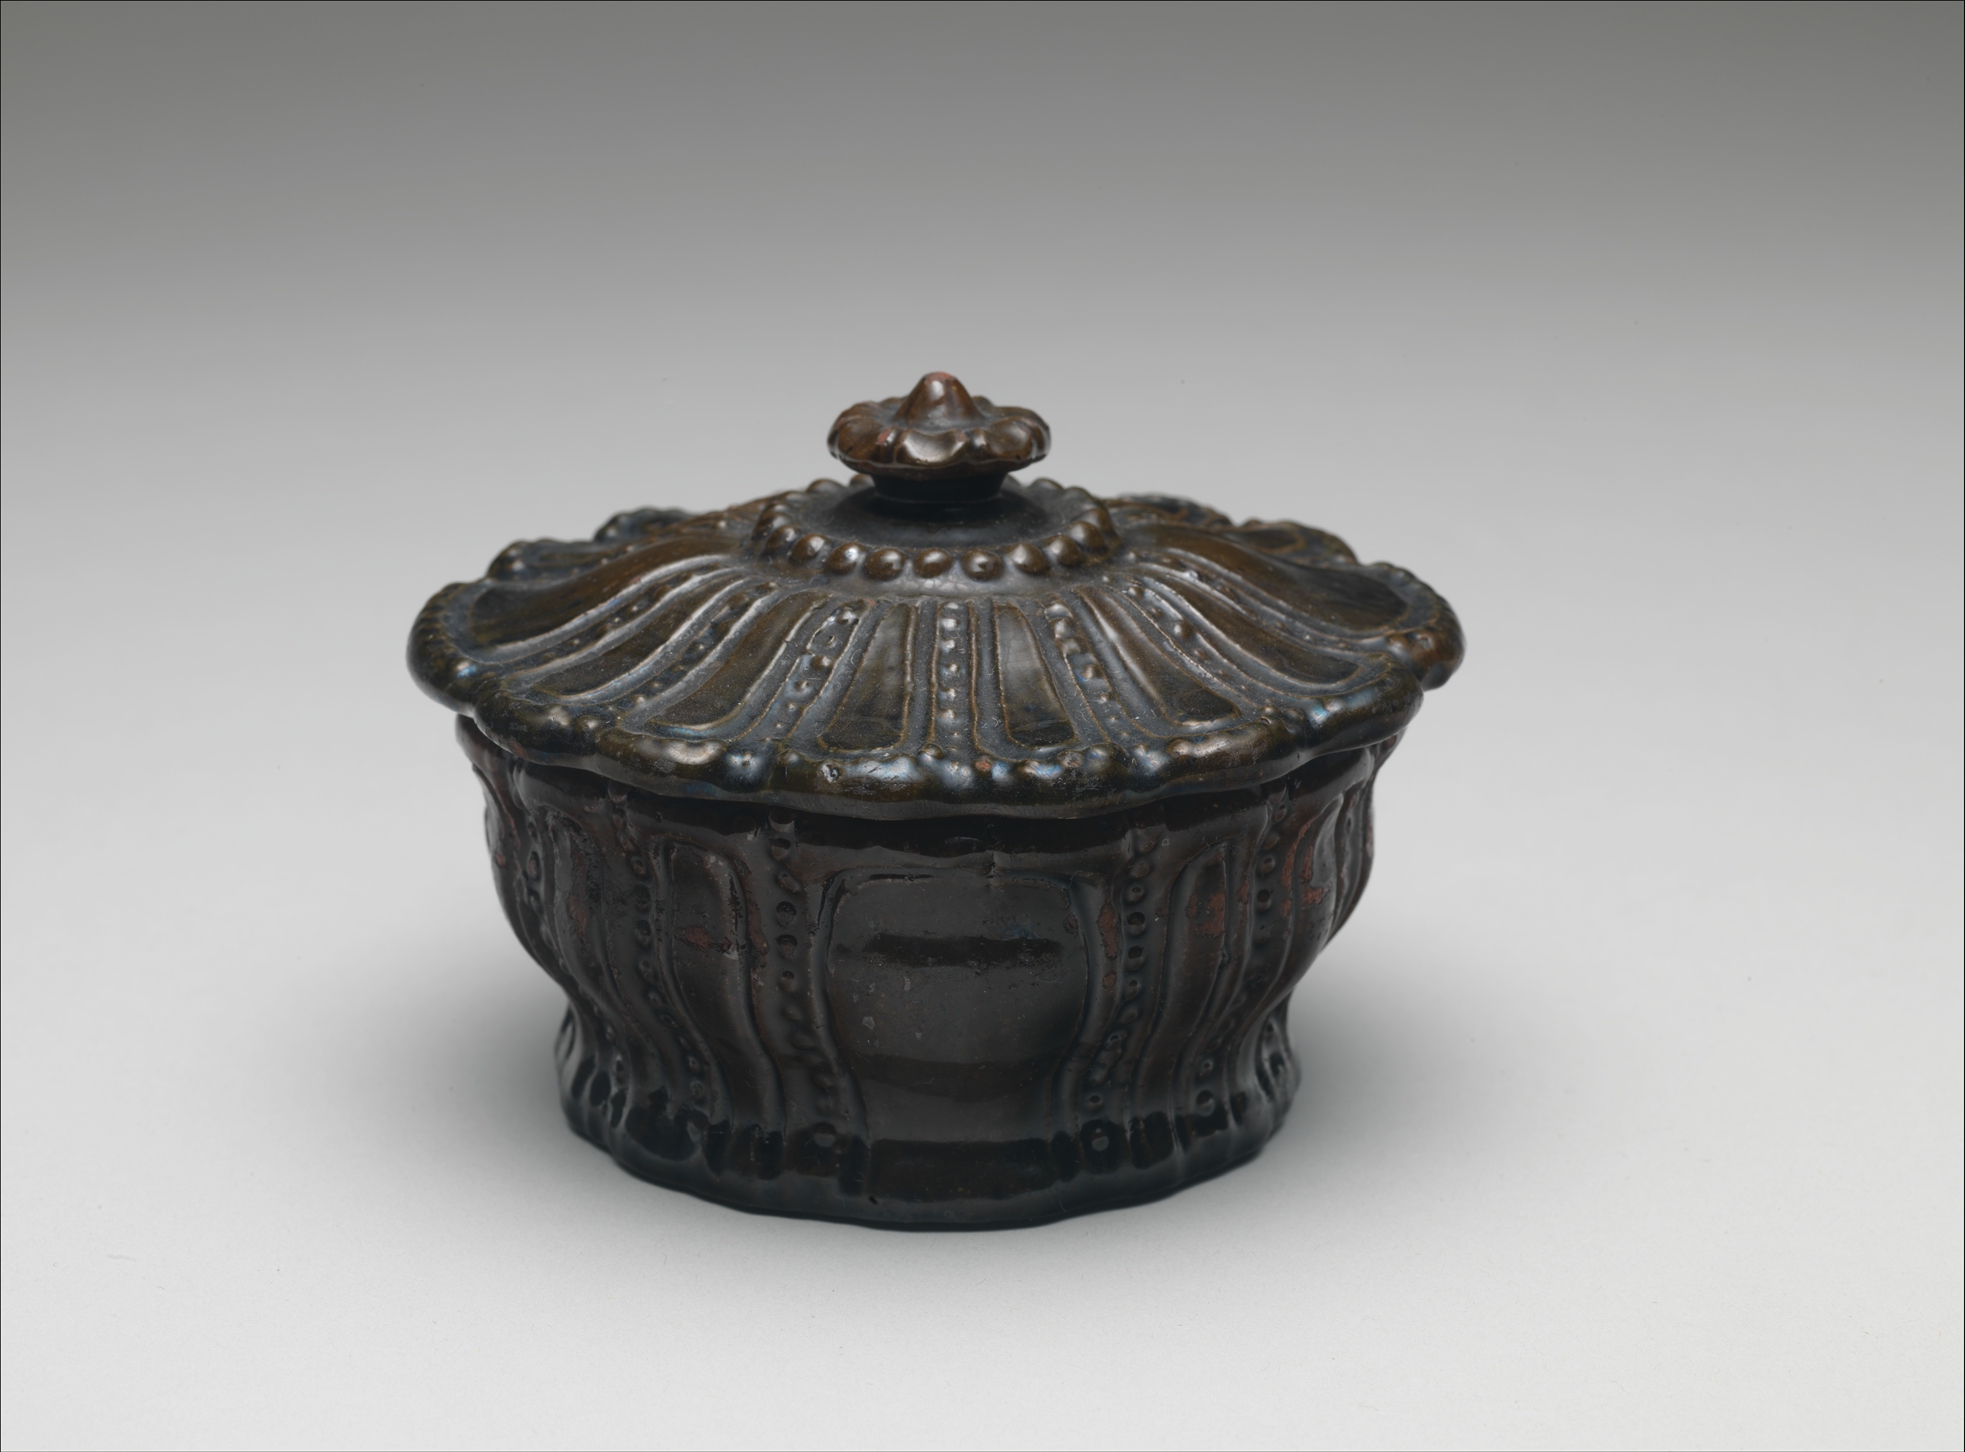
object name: dish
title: Covered Dish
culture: american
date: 1800-1830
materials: earthenware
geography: united states